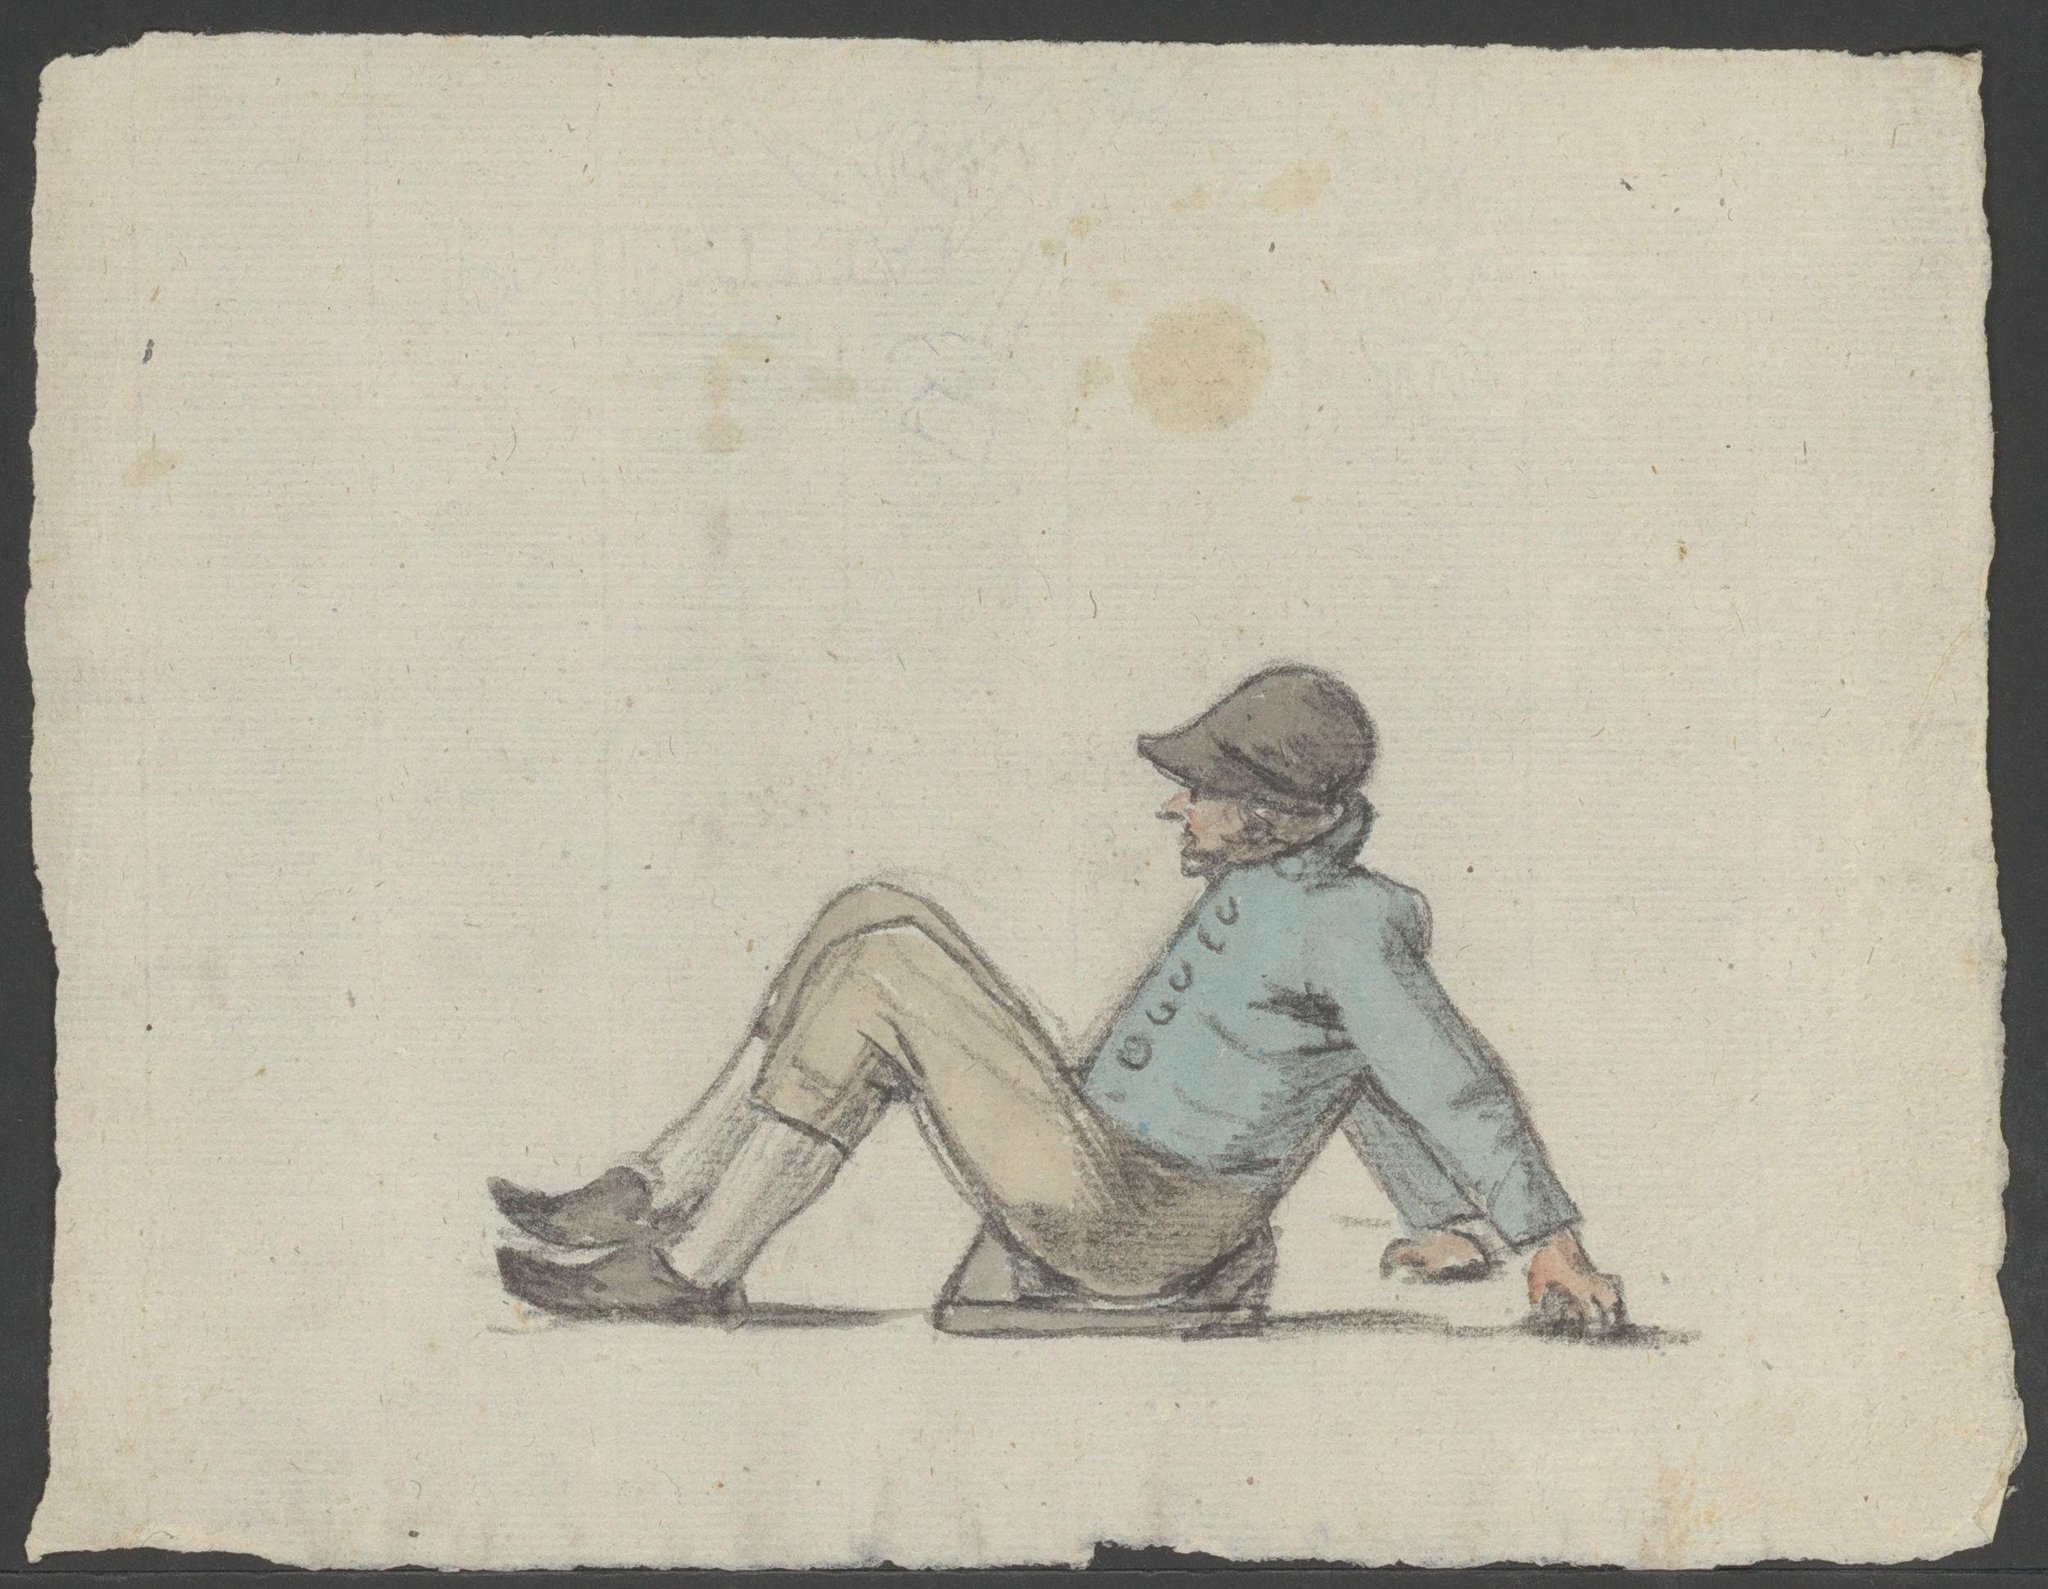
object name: drawing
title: Zittende man met opgetrokken knieën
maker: Anonymous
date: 1800-1899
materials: chalk, paper, watercolor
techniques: brush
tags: sitting figure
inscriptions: collector's mark: Lugt 1641, stamp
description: Onderwerpsrubrieken binnen de Atlas Zeden en Gewoonten: Schoone kunsten, Schilderkunst, Tekeningen.